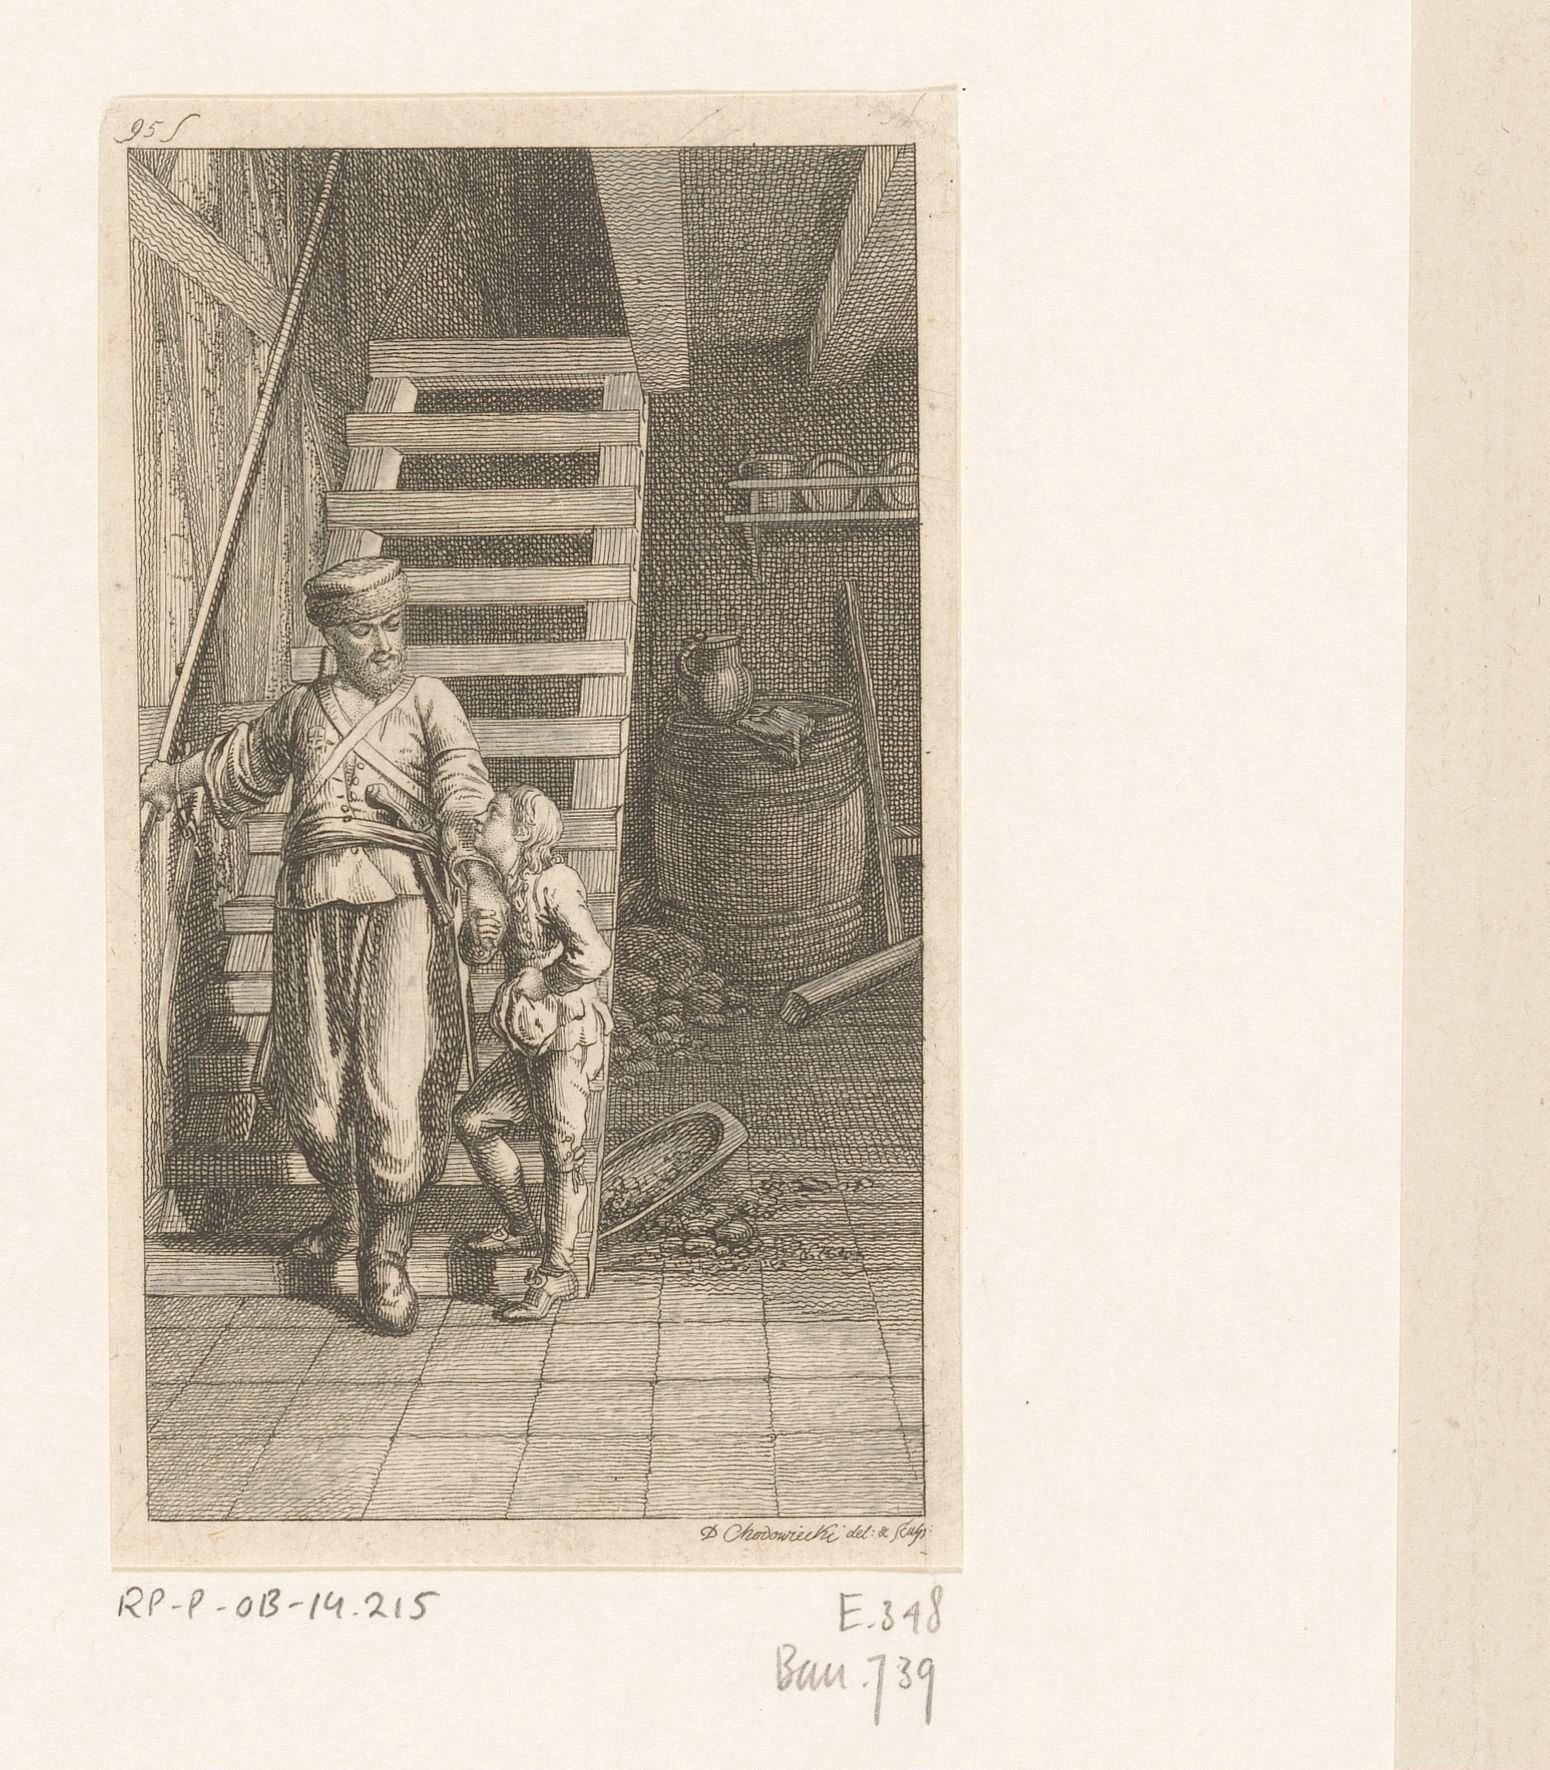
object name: print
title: Wilhelm Blumenthal en de kozak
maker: daniel nikolaus chodowiecki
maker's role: draughtsman, print maker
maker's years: 1726-1801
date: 1780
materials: paper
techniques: etching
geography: berlin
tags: staircase, (military) uniforms, gripping someone by the hand or the wrist; clasped hands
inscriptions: collector's mark: Lugt 2228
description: Prent gebruikt voor: Schummel, Johann Gottlieb. Wilhelm von Blumenthal oder das Kind der Natur (...). 2 dln. Leipzig: Weygandschen Buchhandlung, 1780, dl. 1.